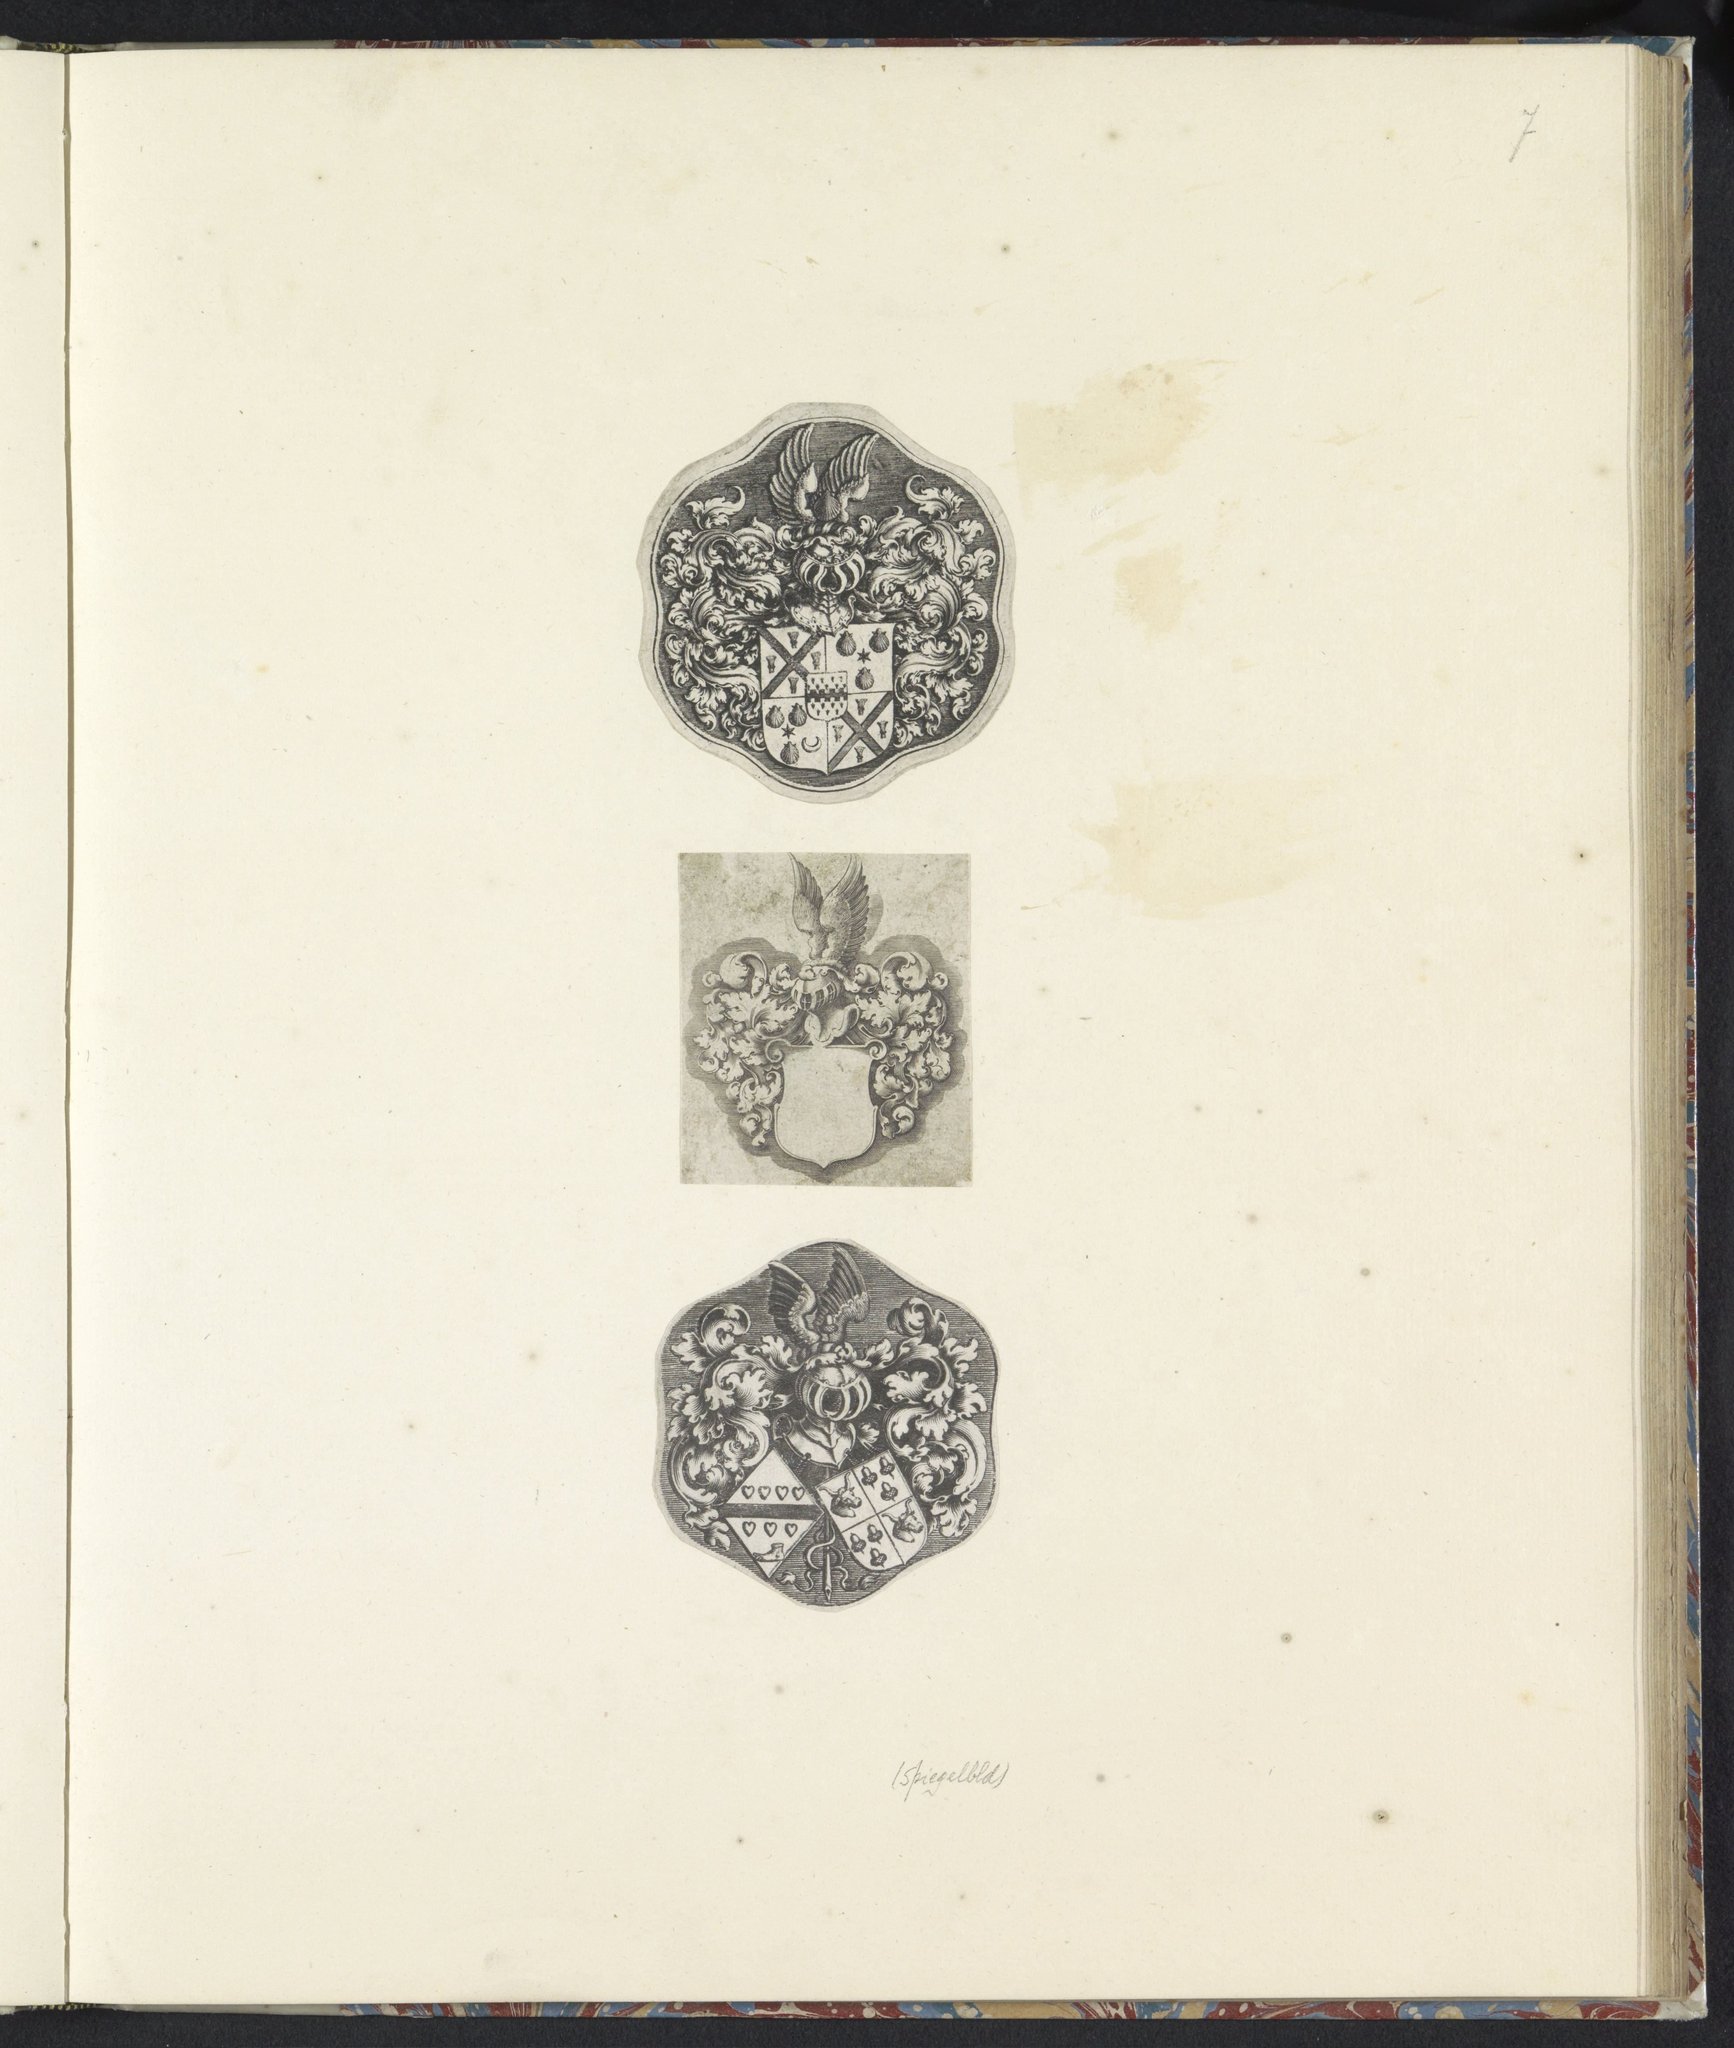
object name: print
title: Drie wapens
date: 1550-1599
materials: paper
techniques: engraving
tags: armorial bearing, heraldry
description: Drie voorstellingen op een albumblad. Het betreffen elk wapens met een gevleugelde helm. Bovenaan een schild met schoven, sterren en schelpen. Het helmteken is een schelp. Onderaan een dubbel schild. Het helmteken (een eikel) en het schild met de twee ossenkoppen en de zes eikels is van de familie Eikelenberg genoemt Hooftman. Het andere schild met een dwarsbalk, harten en een voet. De prenten maken deel uit van een album.